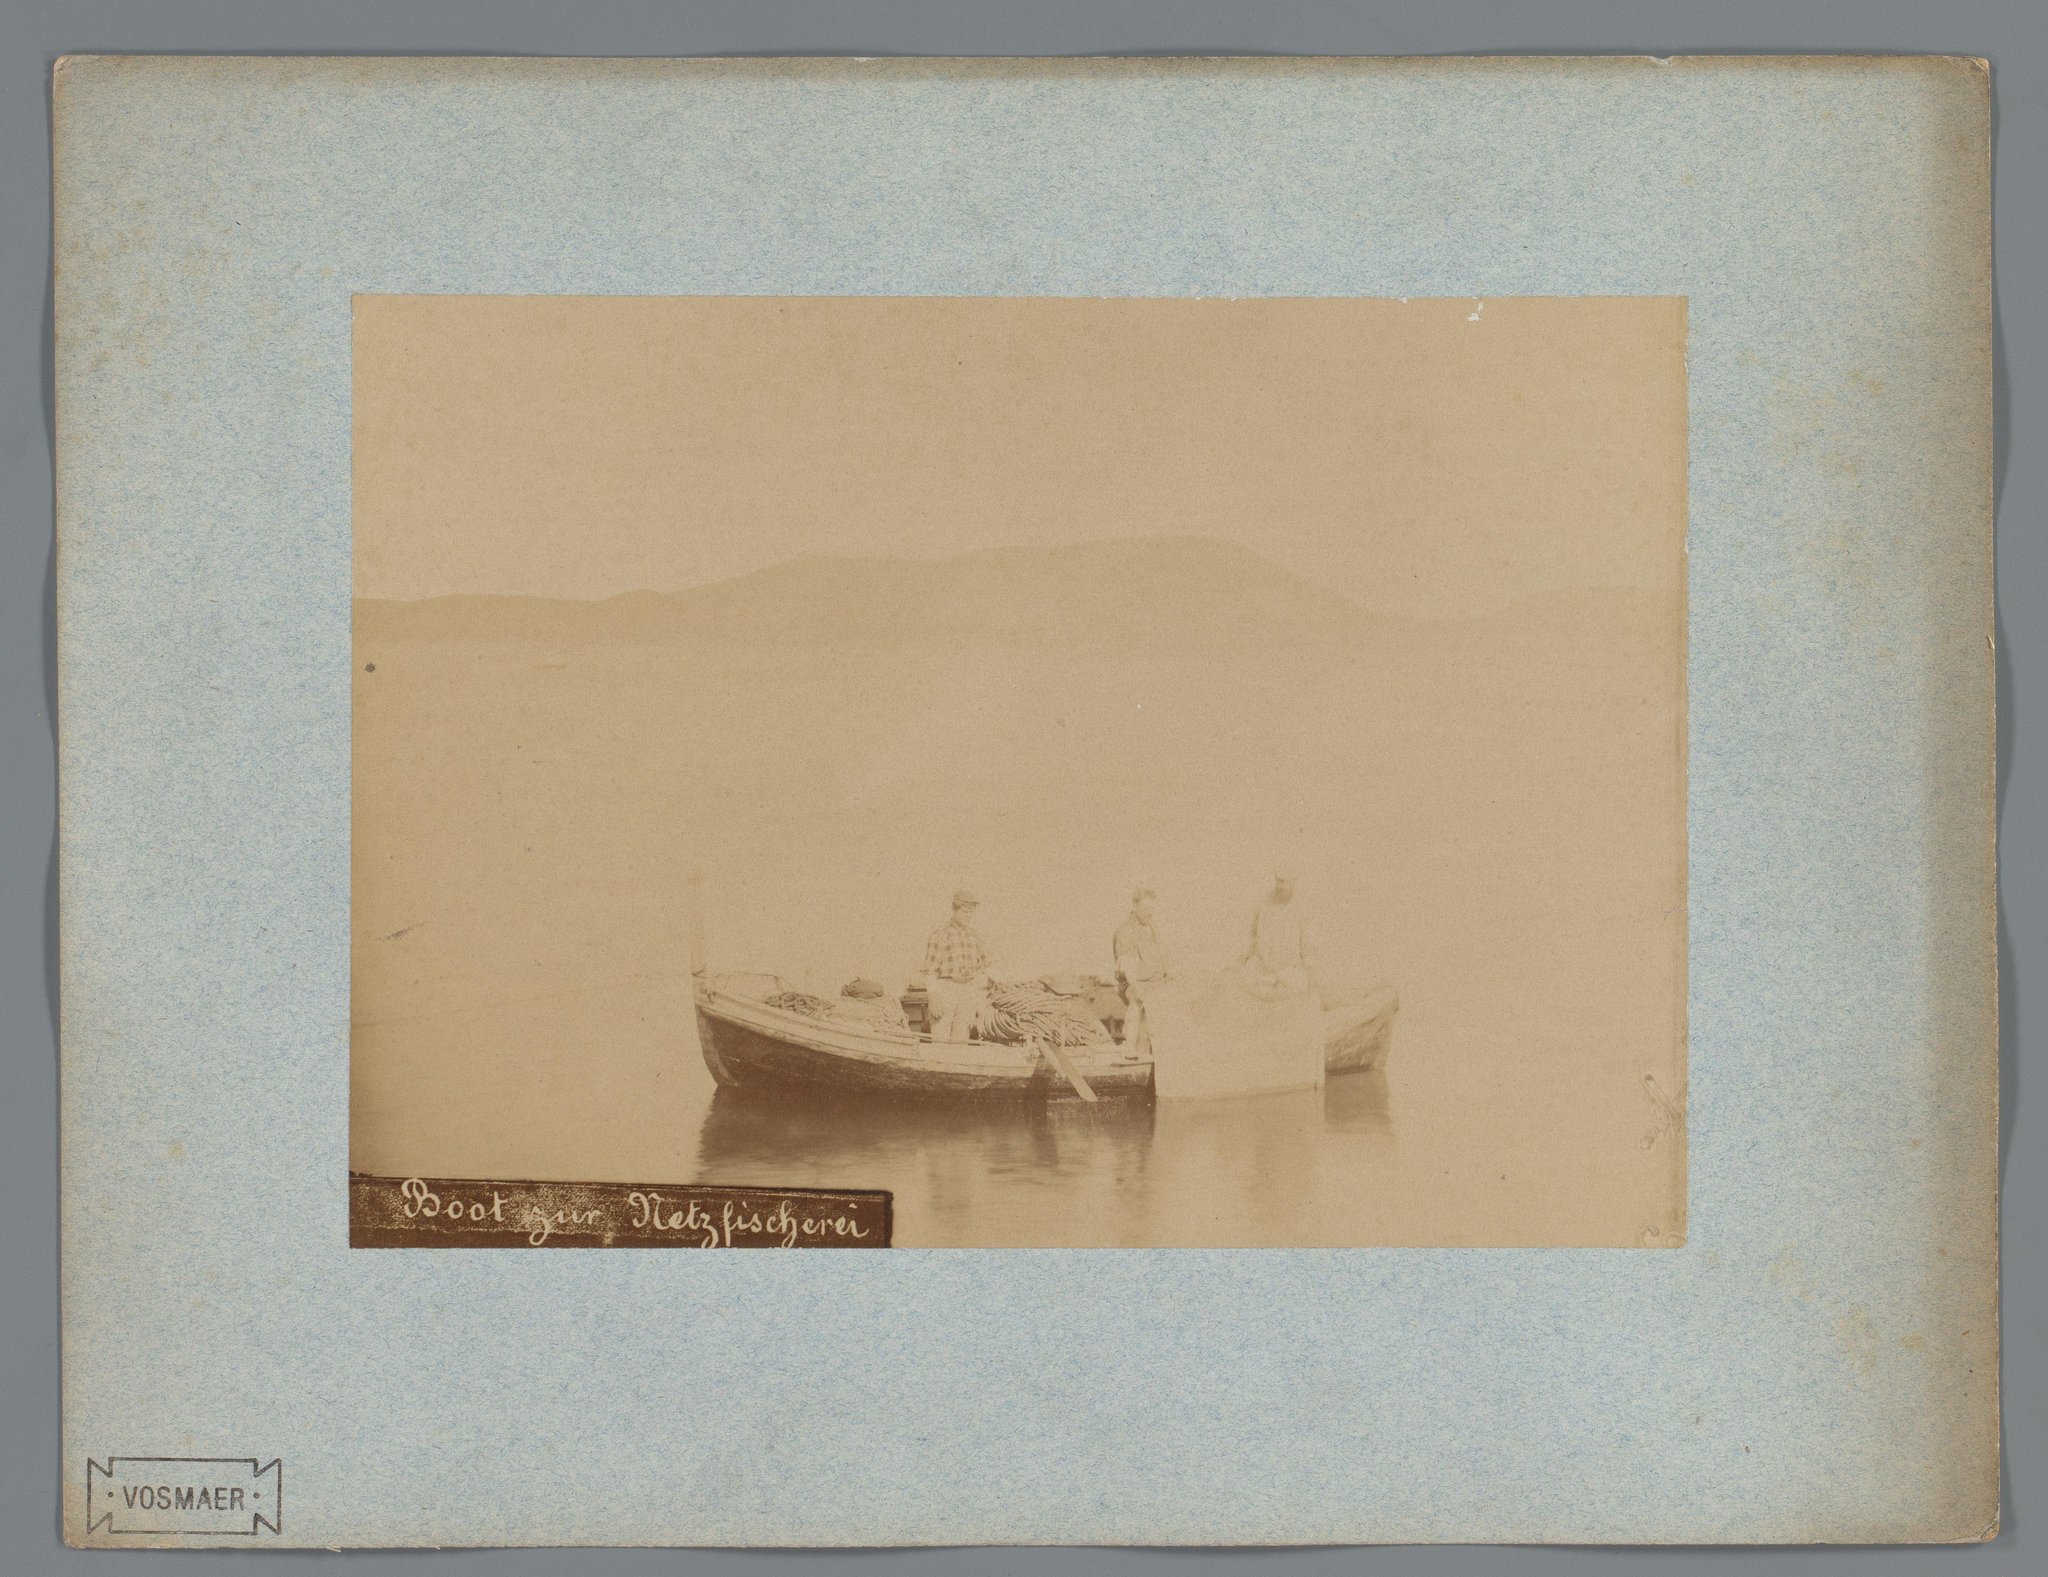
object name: photograph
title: Boot zur Netzfischerei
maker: Anonymous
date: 1851-1900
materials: cardboard, paper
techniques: albumen print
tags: fisherman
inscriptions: collector's mark: ‘VOSMAER’